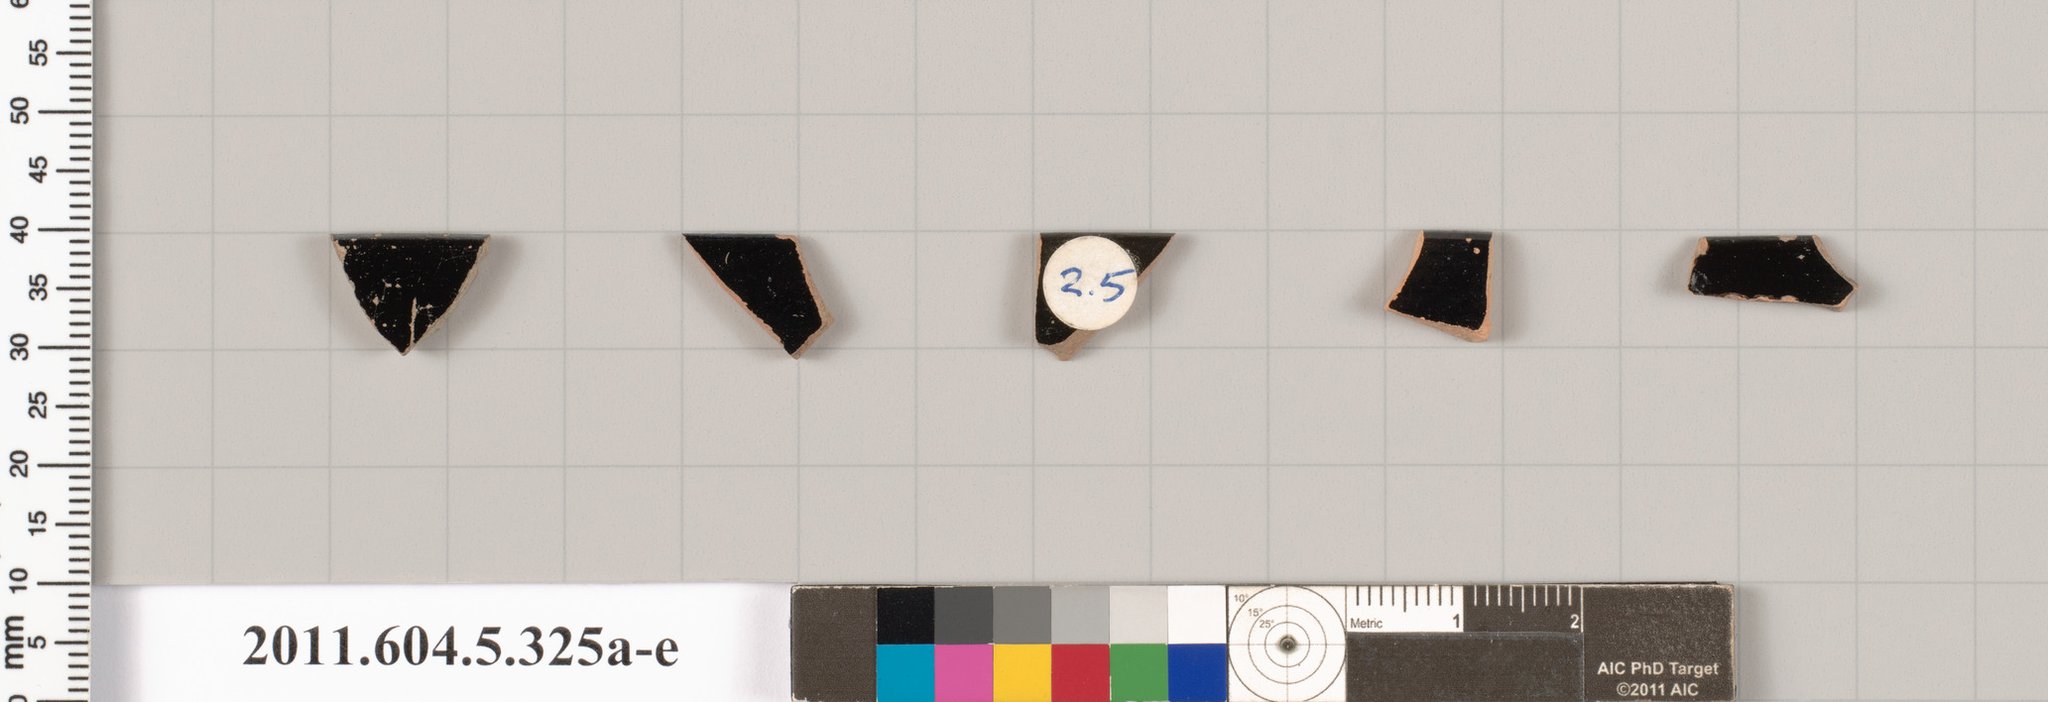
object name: kylix fragment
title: Terracotta rim fragments of kylikes (drinking cups)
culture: greek, attic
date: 600-401 BCE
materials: terracotta